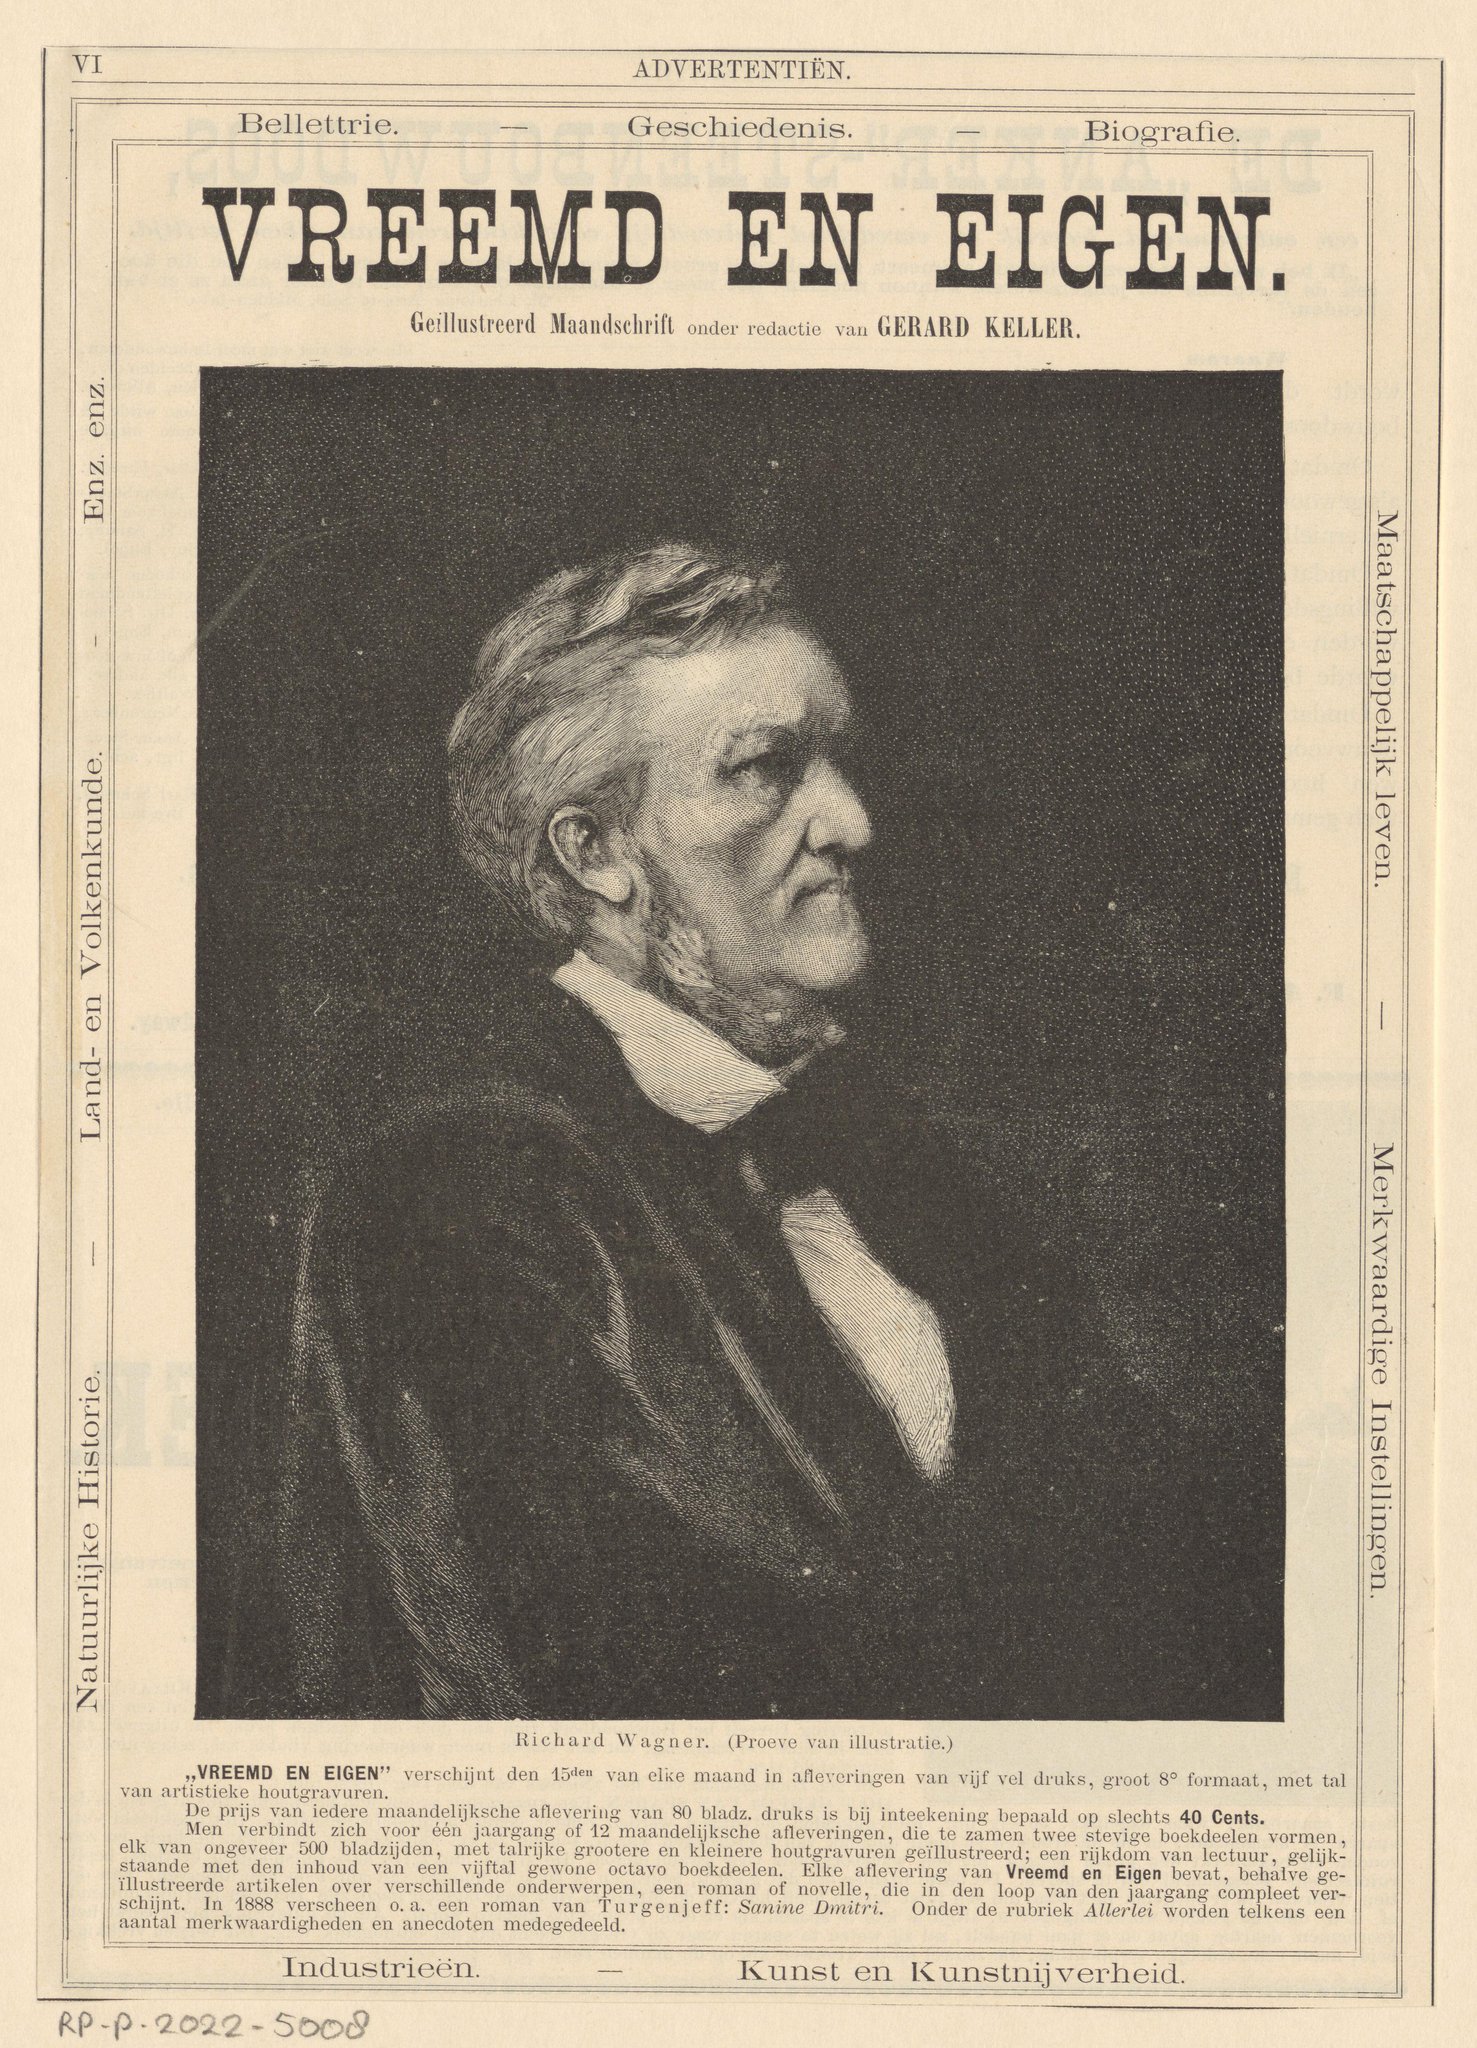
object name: print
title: Portret van Richard Wagner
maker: Anonymous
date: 1889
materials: paper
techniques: letterpress printing, engraving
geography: netherlands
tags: richard wagner, historical persons, portrait of composer